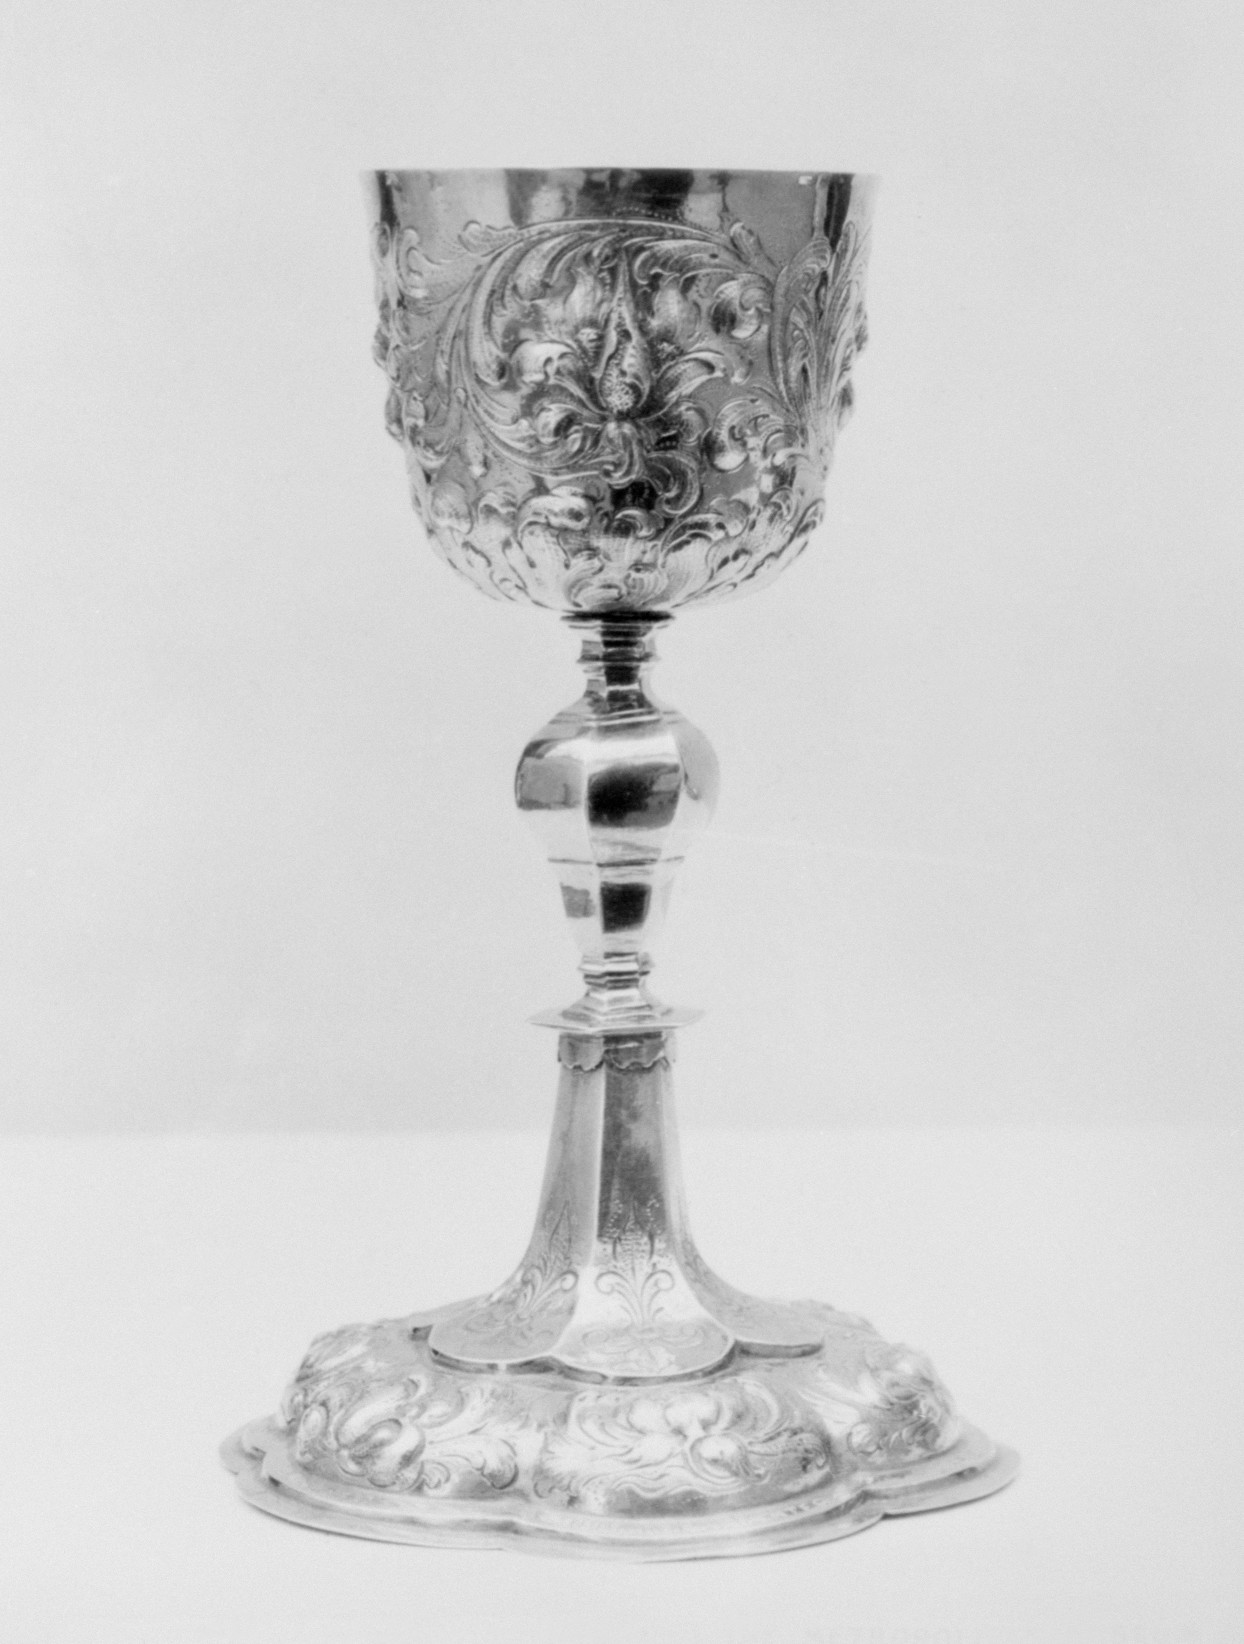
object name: chalice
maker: georg reischl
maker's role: maker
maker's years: 1600-1700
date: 1675-1700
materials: silver gilt